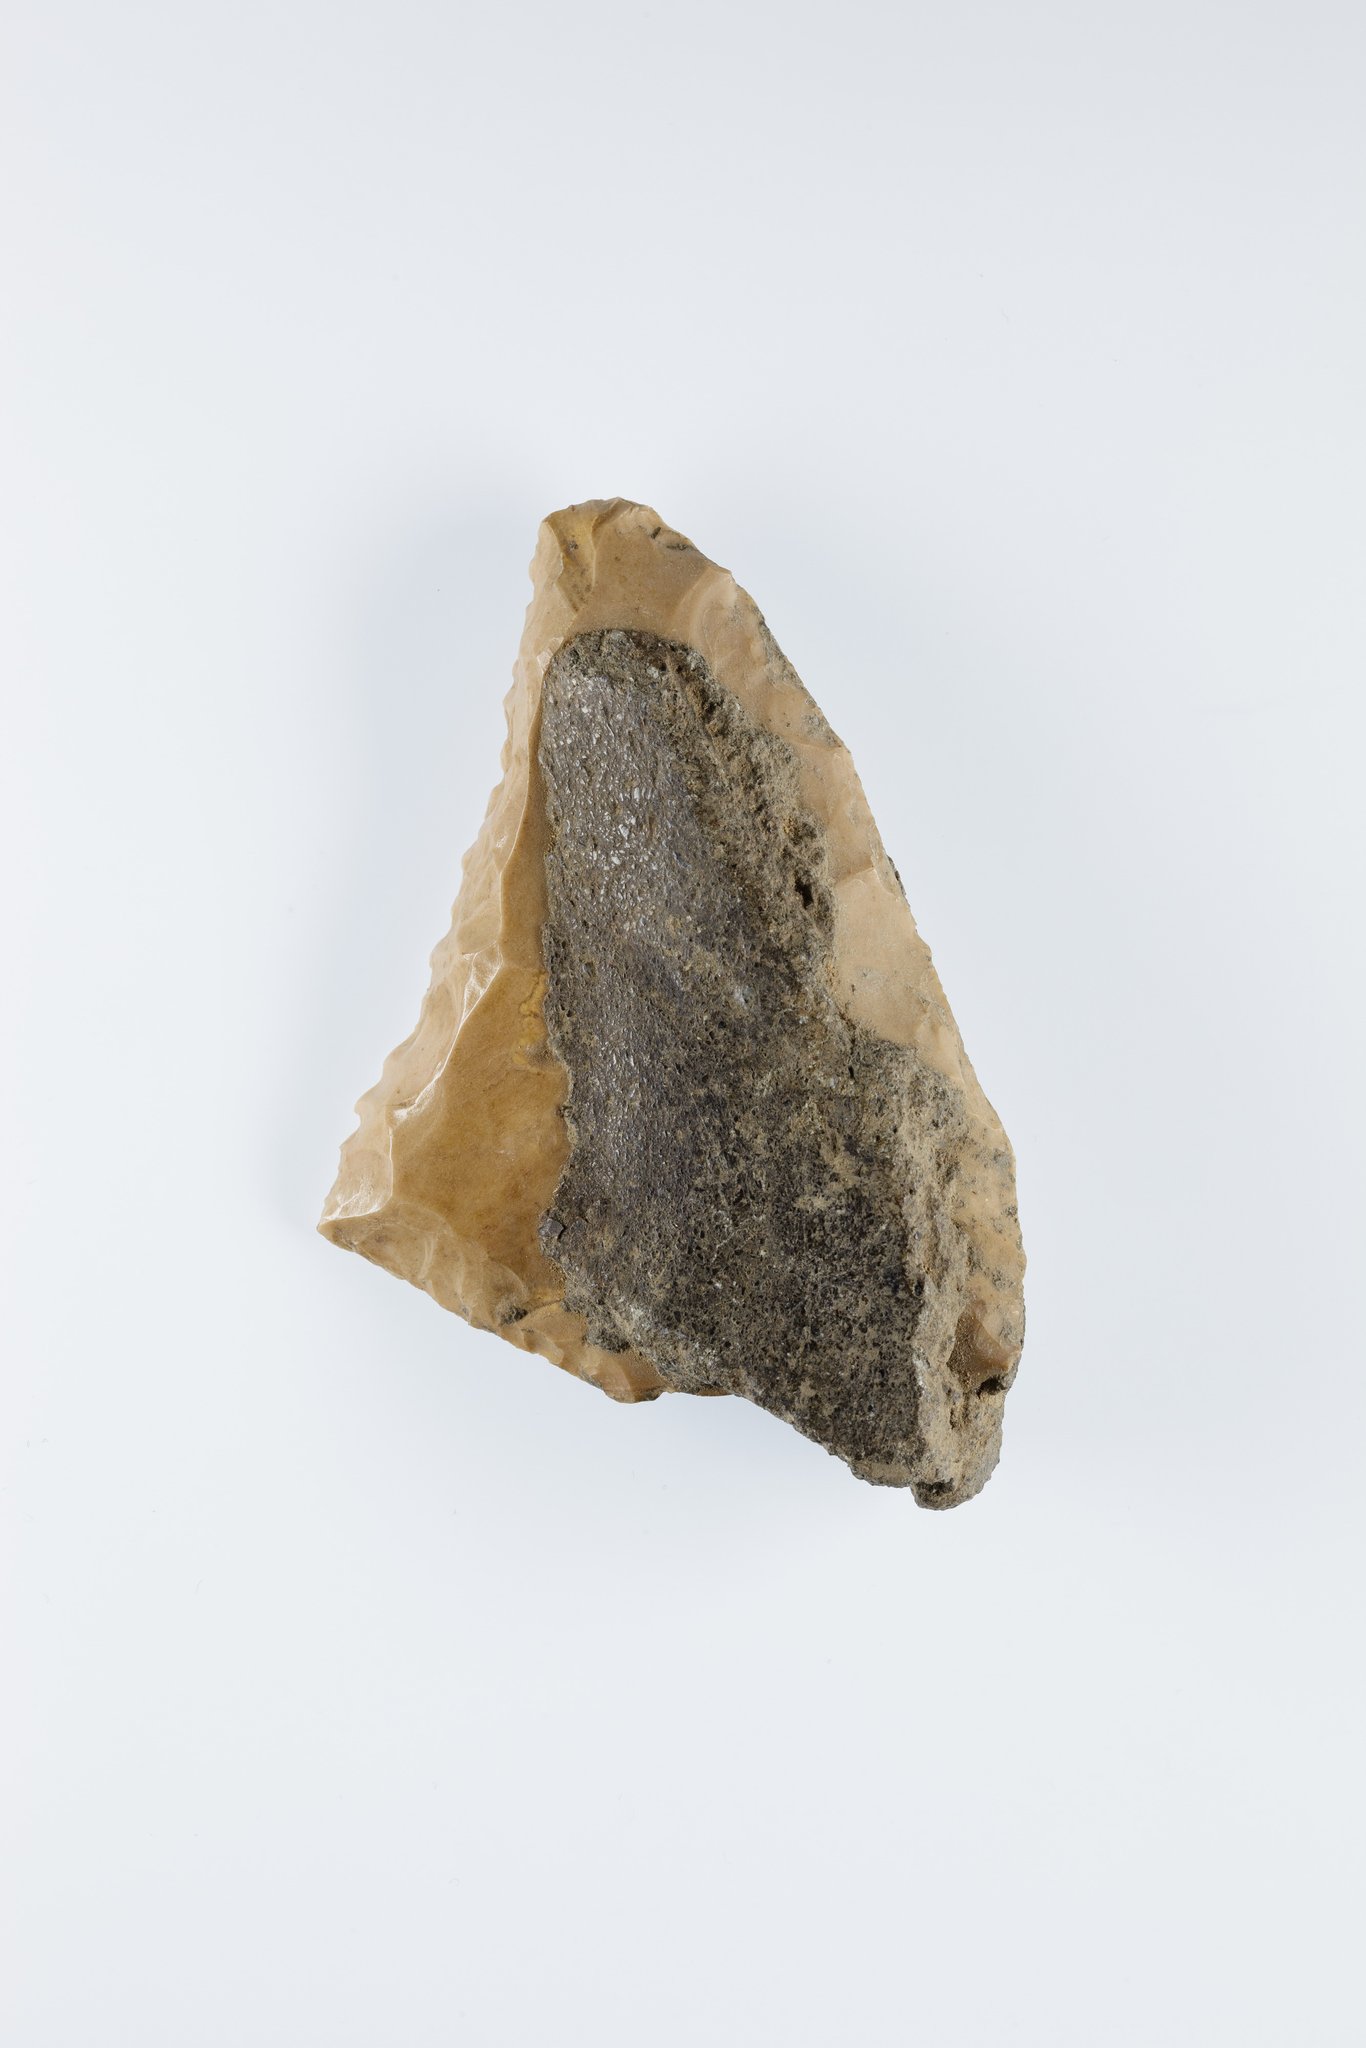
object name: sickle, denticulate, truncated, backed, geometric, tool, element, adhesive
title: Sickle Insert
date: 1184-664 BCE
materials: stone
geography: egypt